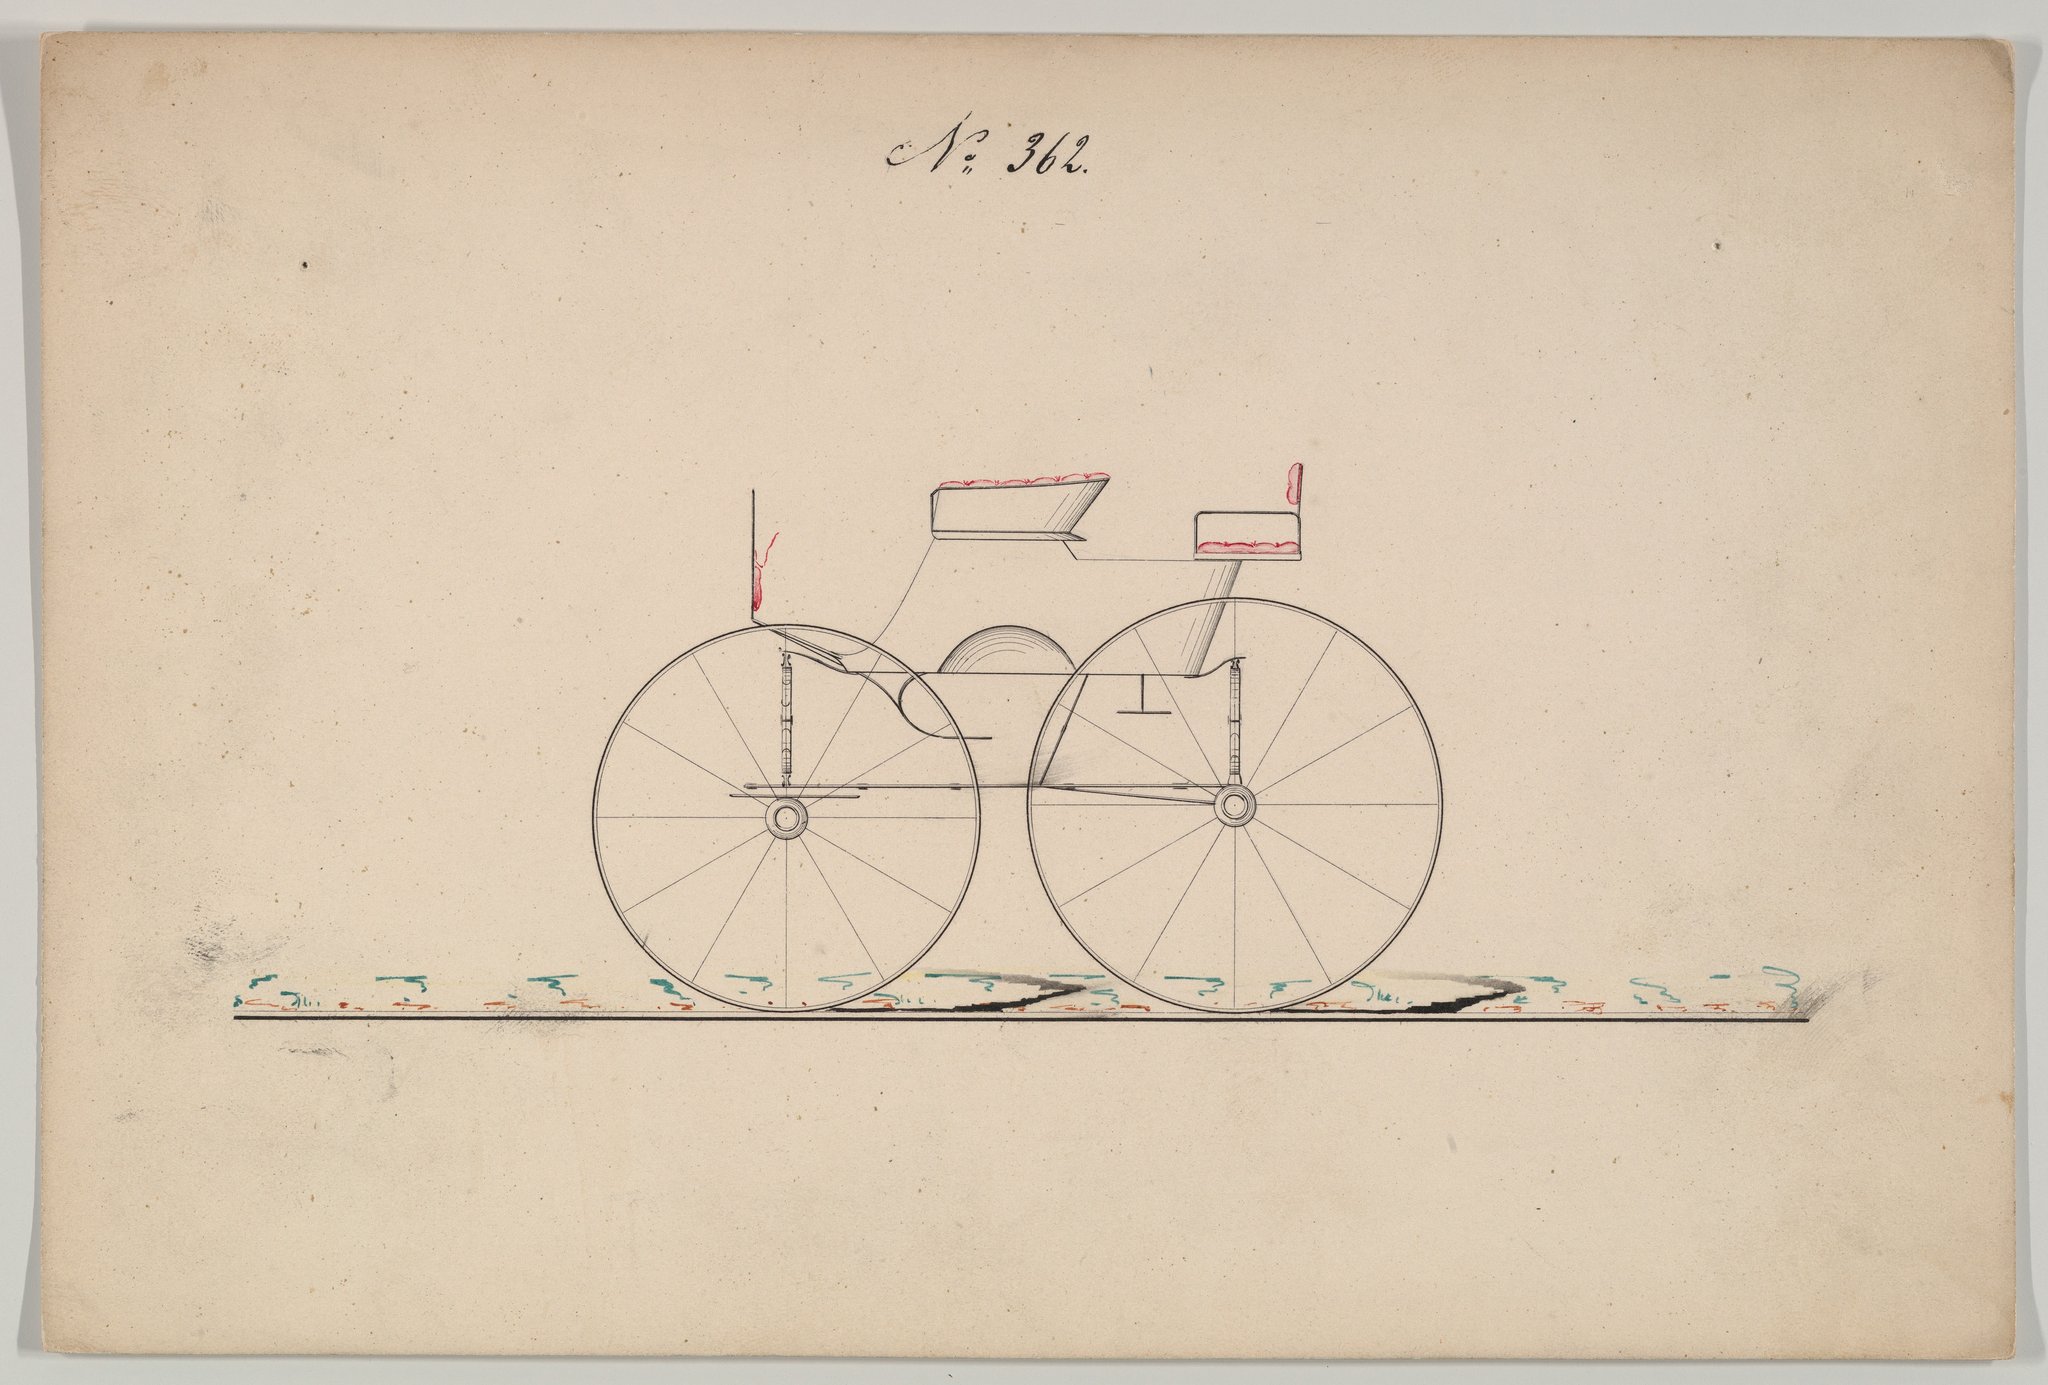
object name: drawing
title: Dog Cart Phaeton # 362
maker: brewster & co.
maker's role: manufacturer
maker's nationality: american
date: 1865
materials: gouache, ink, watercolor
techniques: pen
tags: carriages